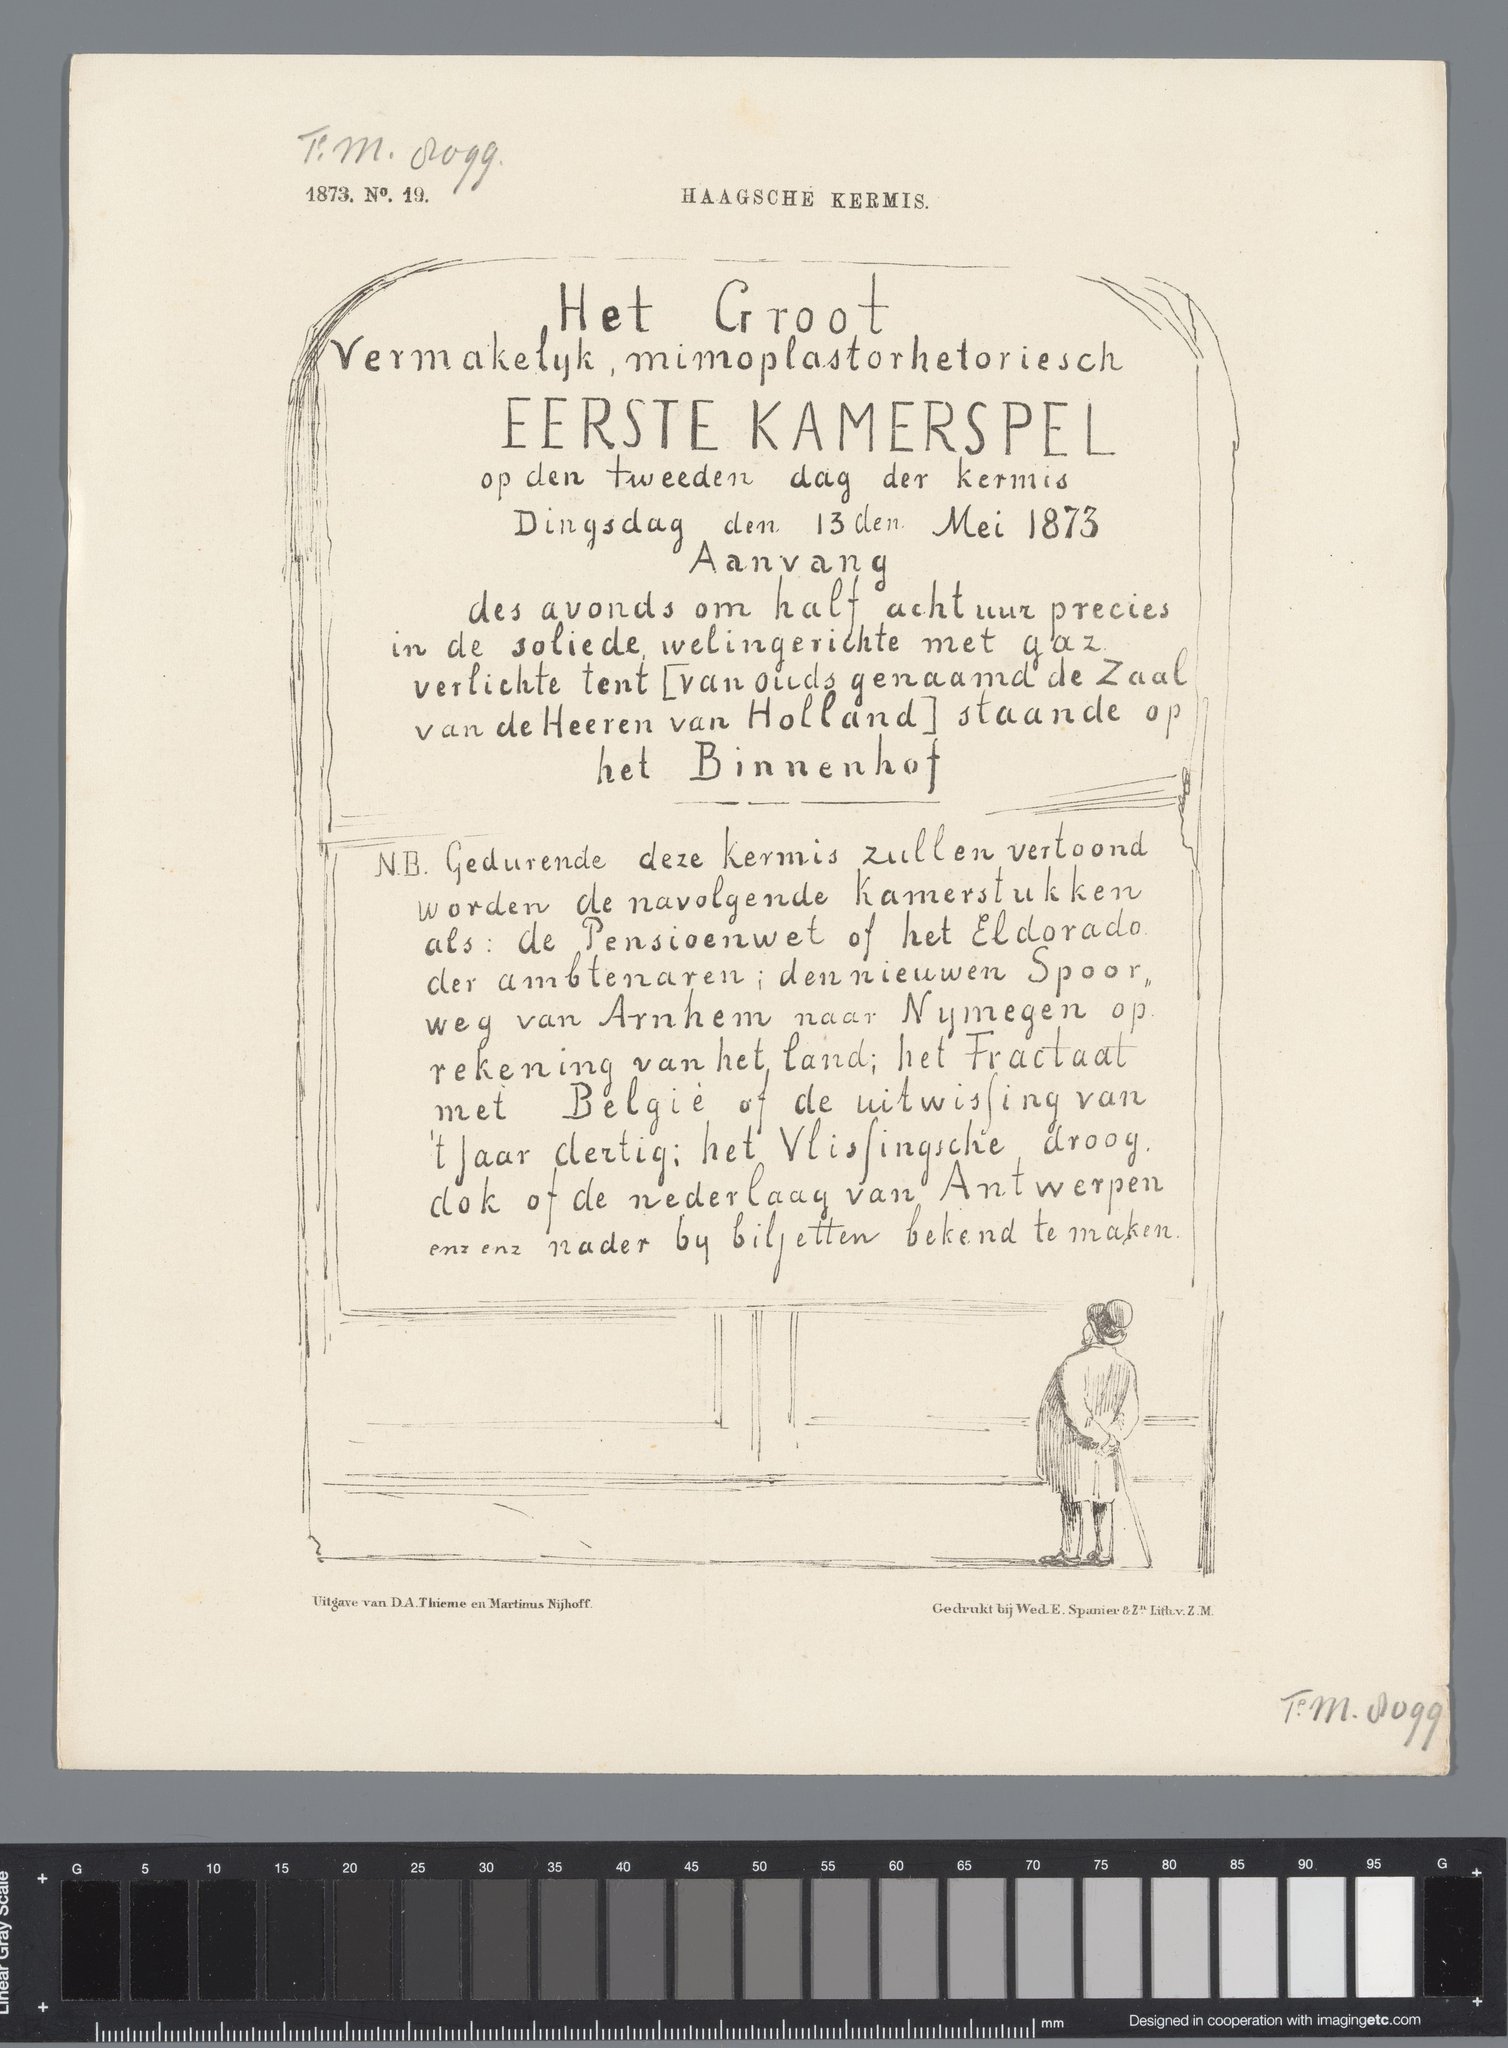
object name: cartoon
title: Spotprent op de opening van de Eerste Kamer na het Paasreces, 1873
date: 1873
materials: paper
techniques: lithograph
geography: netherlands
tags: pleasure fair and circus, the hague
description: Spotprent op de opening van de Eerste Kamer na het Paasreces, dat samenviel met de Haagse kermis. Plaat verschenen bij het weekblad De Nederlandsche Spectator, nr. 19, 1873.